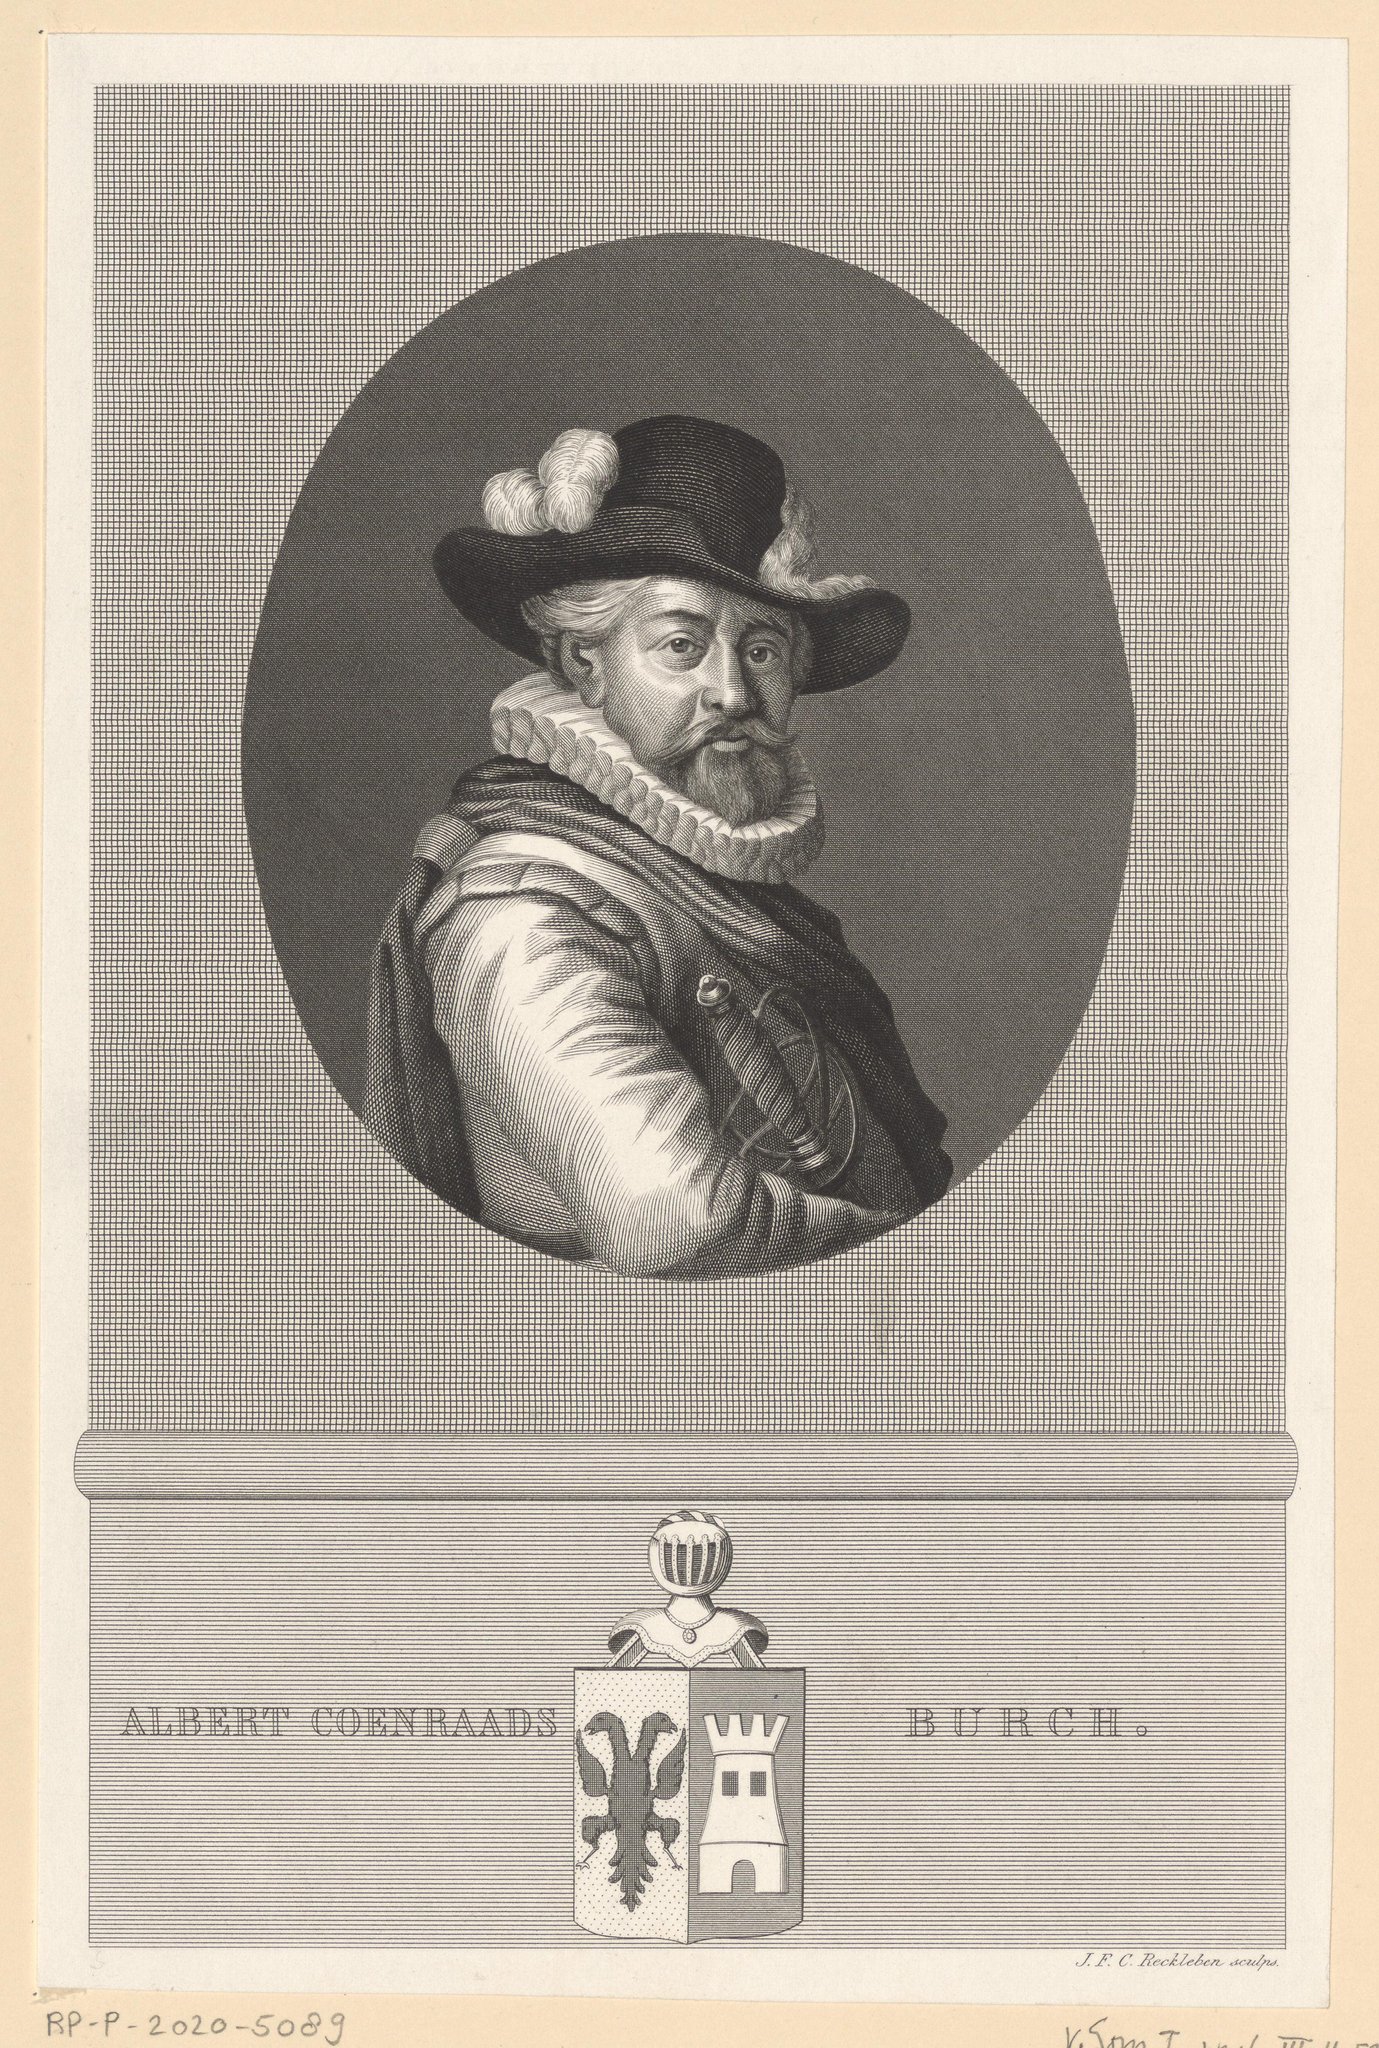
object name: print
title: Portret van Albert Coenraads Burgh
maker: jan frederik christiaan reckleben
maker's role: print maker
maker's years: 1819-1879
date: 1863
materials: paper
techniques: engraving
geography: amsterdam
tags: amsterdam, historical persons, armorial bearing, heraldry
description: Prent uit: Arend, Johannes Pieter. Algemeene geschiedenis des vaderlands van de vroegste tijden tot op heden. Amsterdam: C. Schleijer en zoon, 1863, dl. 3-4.